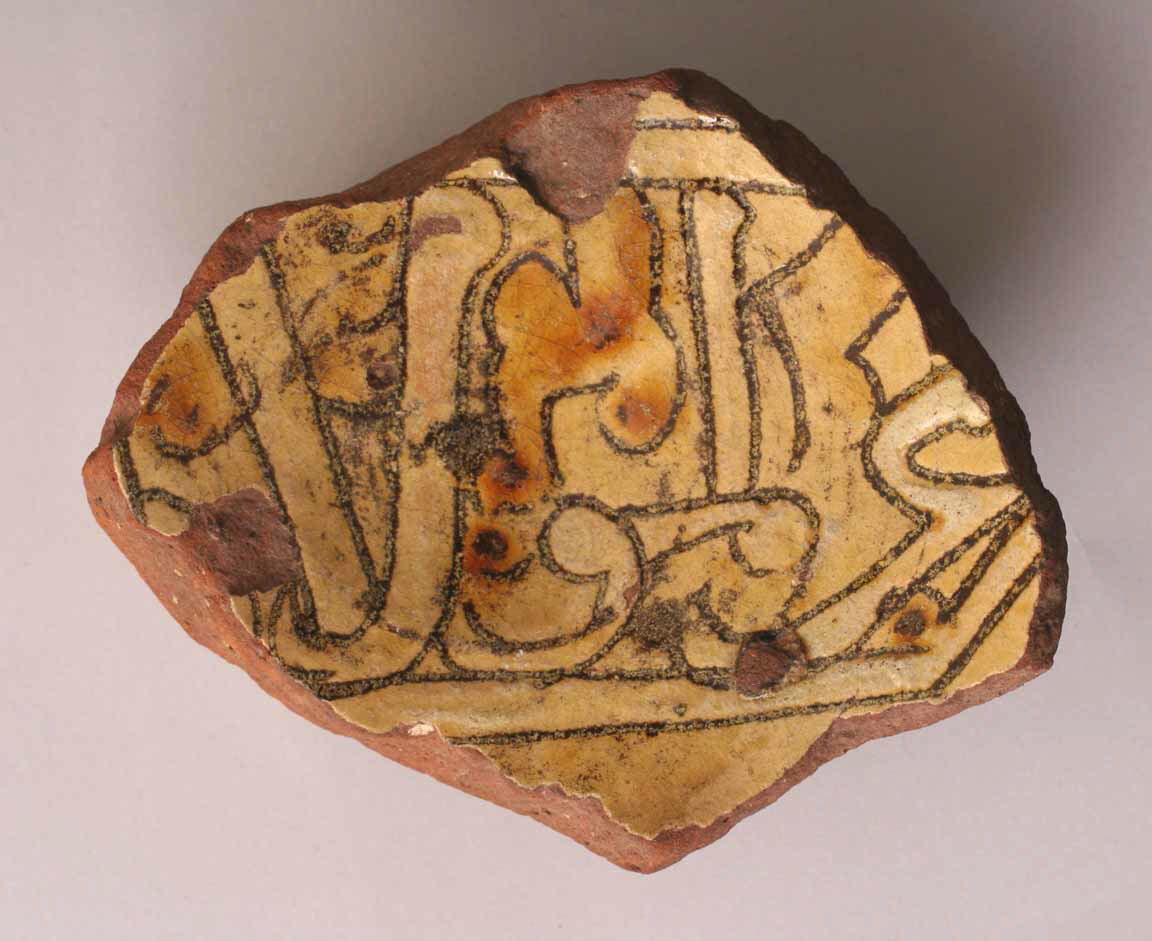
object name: ceramic fragment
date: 1301-1500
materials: earthenware, glaze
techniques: coloring, incising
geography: egypt